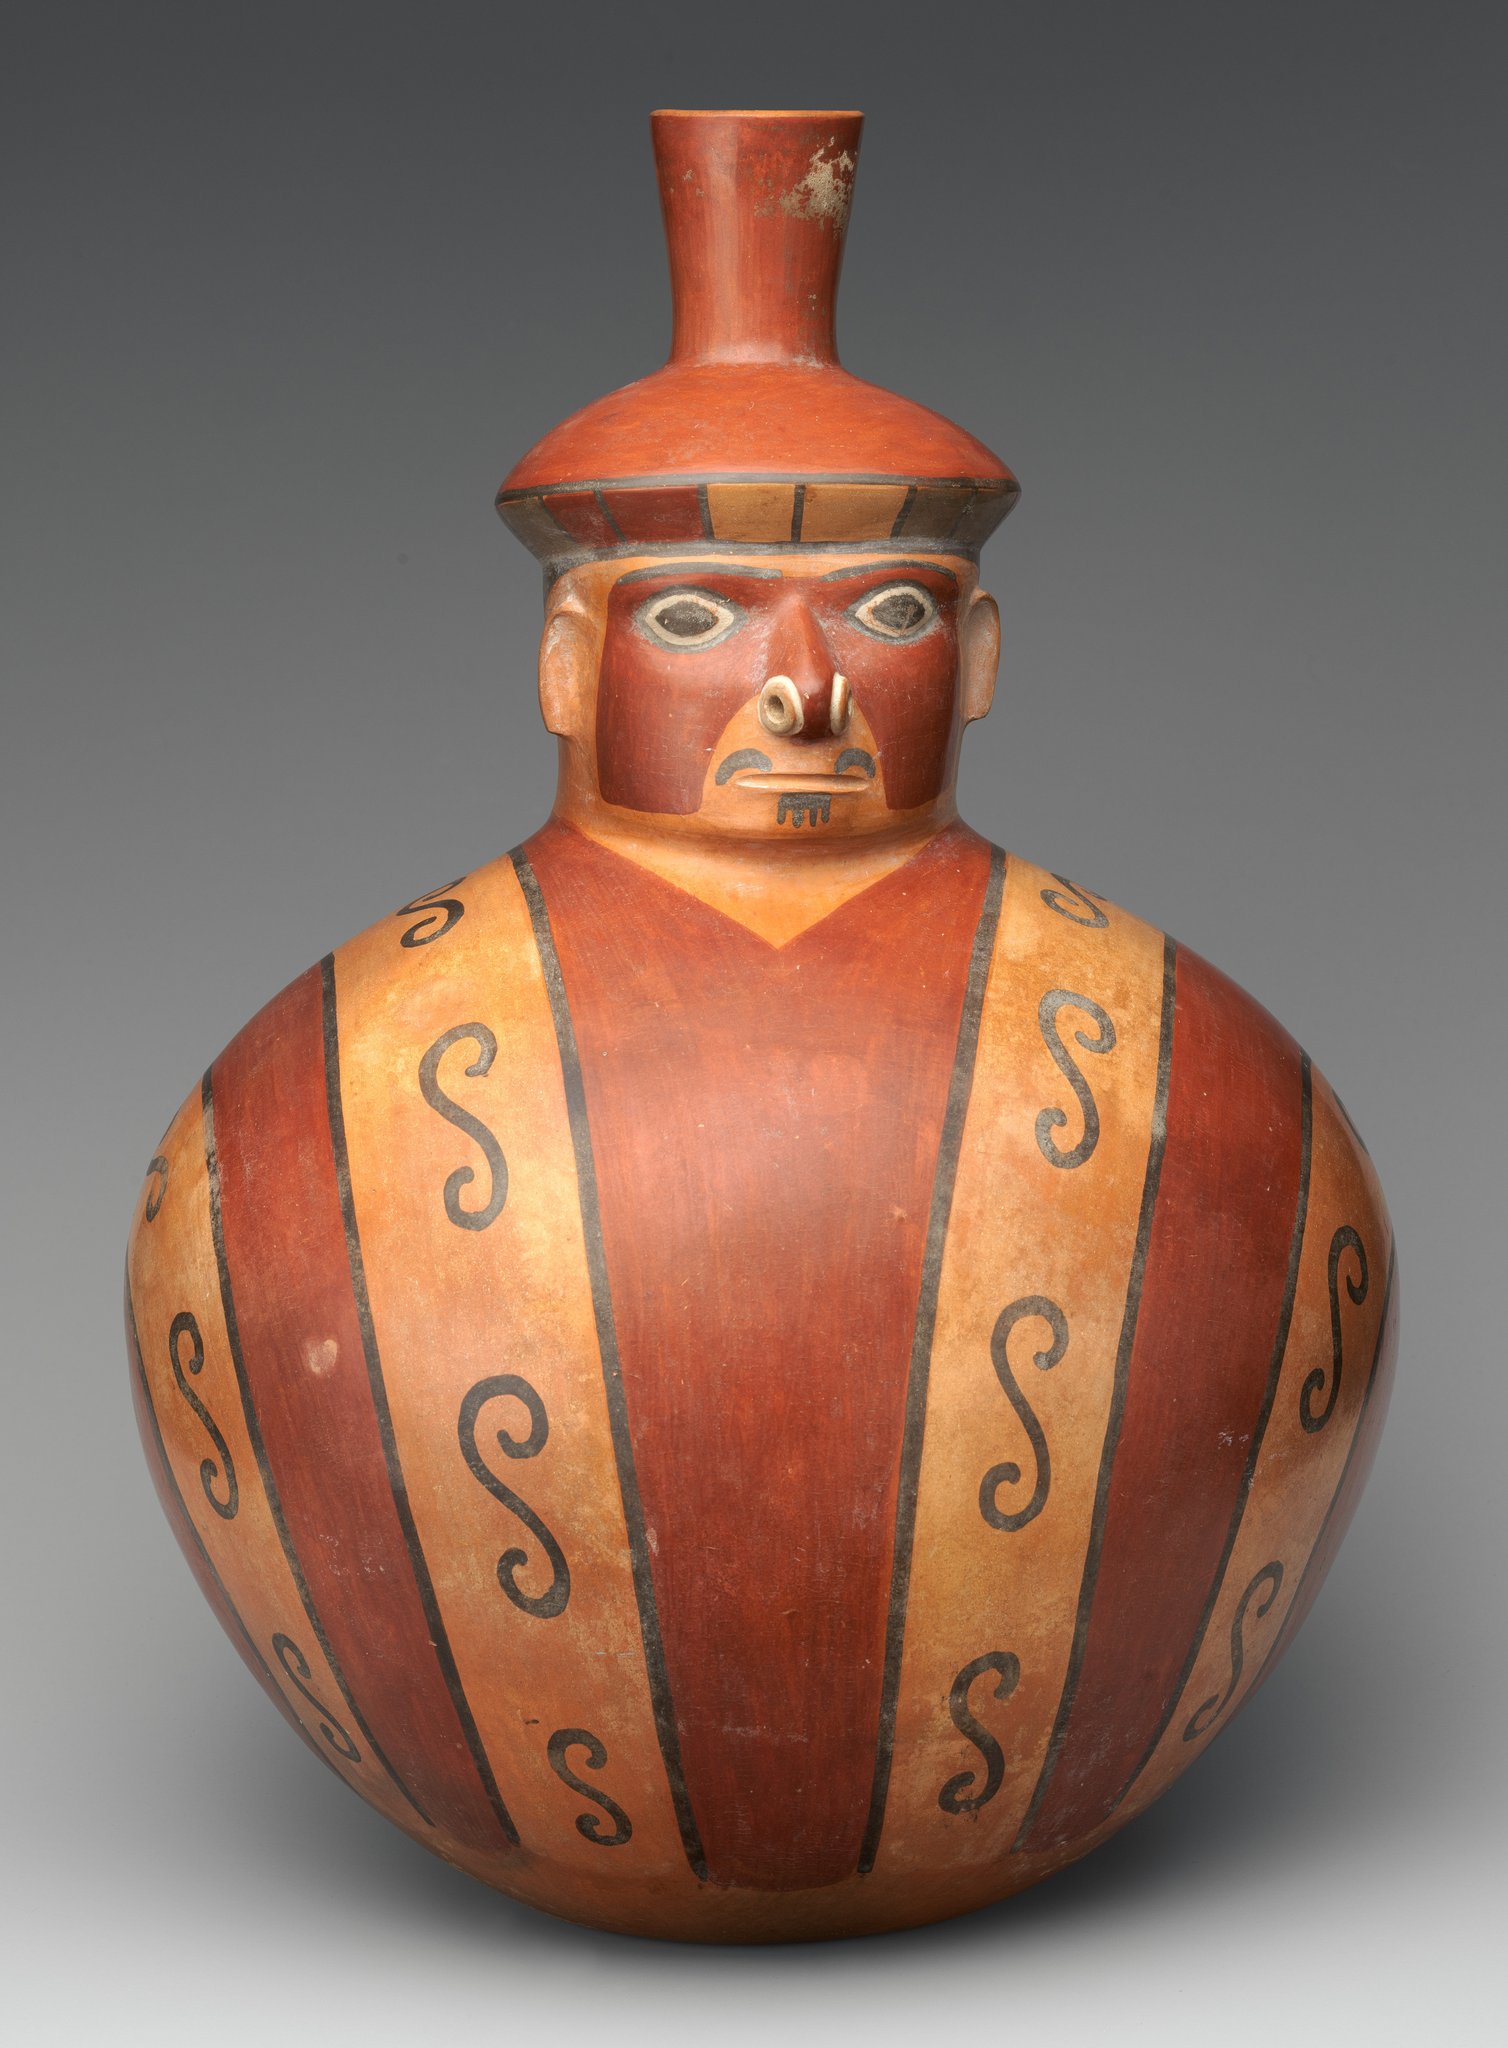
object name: bottle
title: Effigy bottle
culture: wari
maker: wari artist(s)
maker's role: artist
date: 650-1000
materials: ceramic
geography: peru